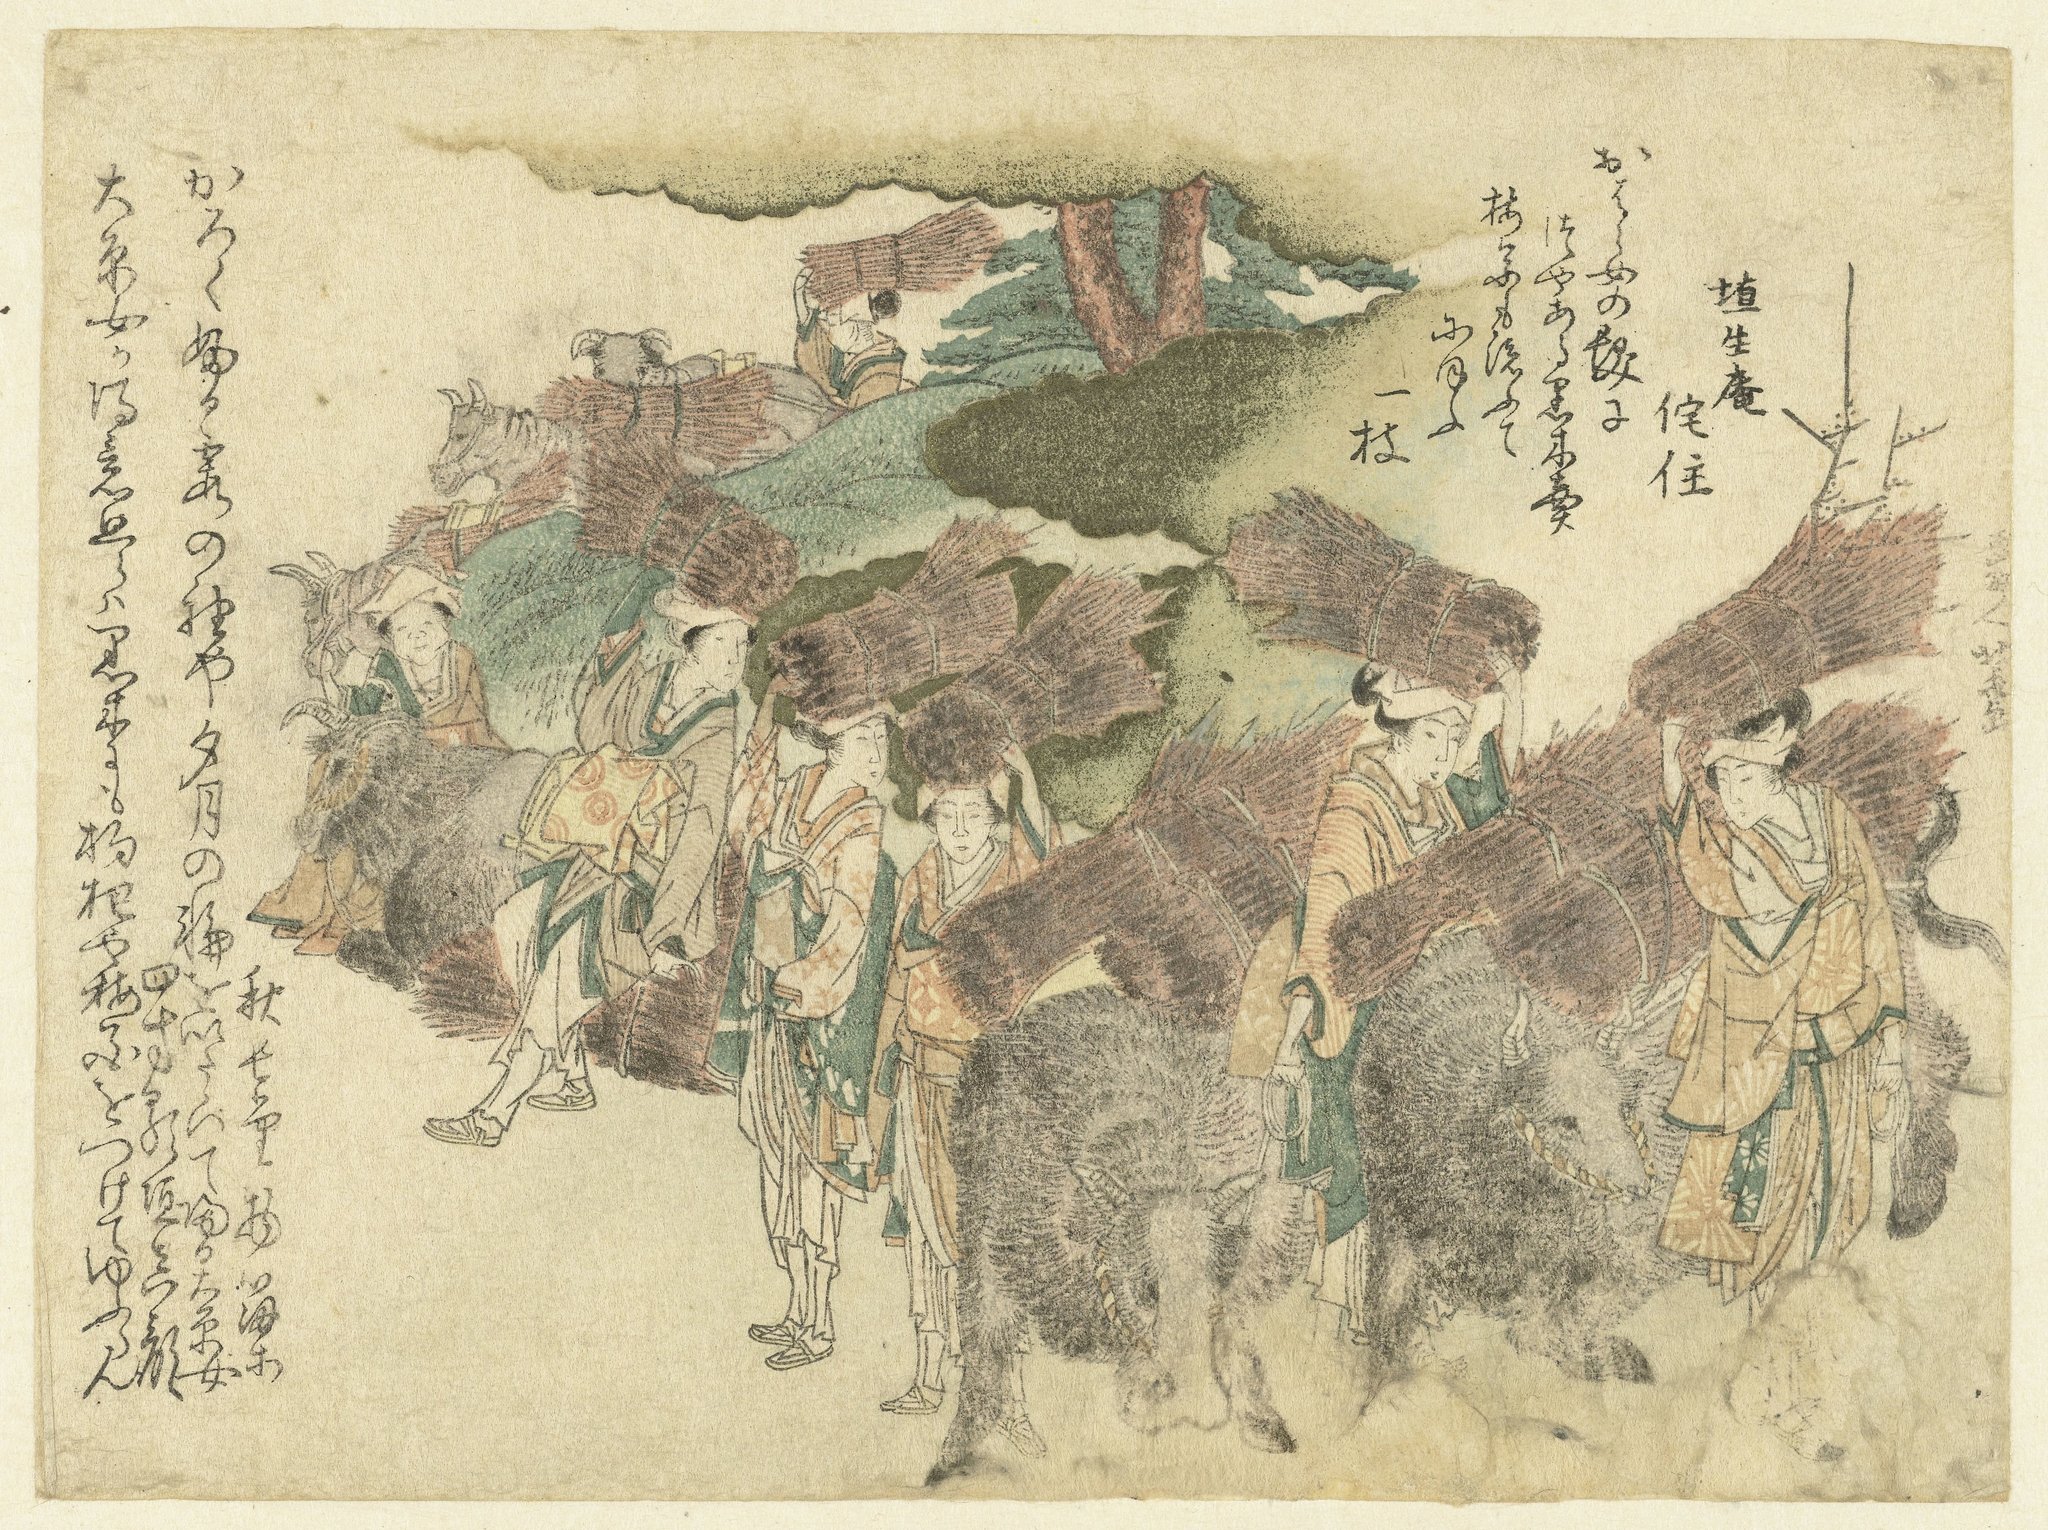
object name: print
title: Vrouwen uit het dorp Ôhara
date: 1805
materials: paper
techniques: blind stamped, woodcut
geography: japan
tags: ox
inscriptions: collector's mark, verso, stamped: Lugt 2228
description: Een surimono is een luxe uitgevoerde prent waarop beeld met één of meerdere gedichten gecombineerd is. Bij het drukken van een surimono werd vaak gebruik gemaakt van dikker papier, blinddruk en metaal pigmenten, zoals koper- en zilverpoeder. De prenten werden vaak in opdracht van dichters gemaakt en als exclusief geschenk aan vrienden en relaties gegeven. Een egoyomi is een kalender prent, waarop de aanduiding voor de maanden verstopt zit in het ontwerp. Vaak werden egoyomi net als surimono in eigen beheer uitgegeven en aan vrienden kado gedaan. In Japan gebruikte men tot 1873 een maankalender, waarbij de volgorde van de lange en de korte maanden jaarlijks varieerde. Omdat er maar een klein aantal uitgevers kalenders mocht maken, waren particulier uitgeven kalender prenten tegen de regels van de overheid. Om deze regels te omzeilen werden de kalendergegevens verstopt in het prentontwerp.